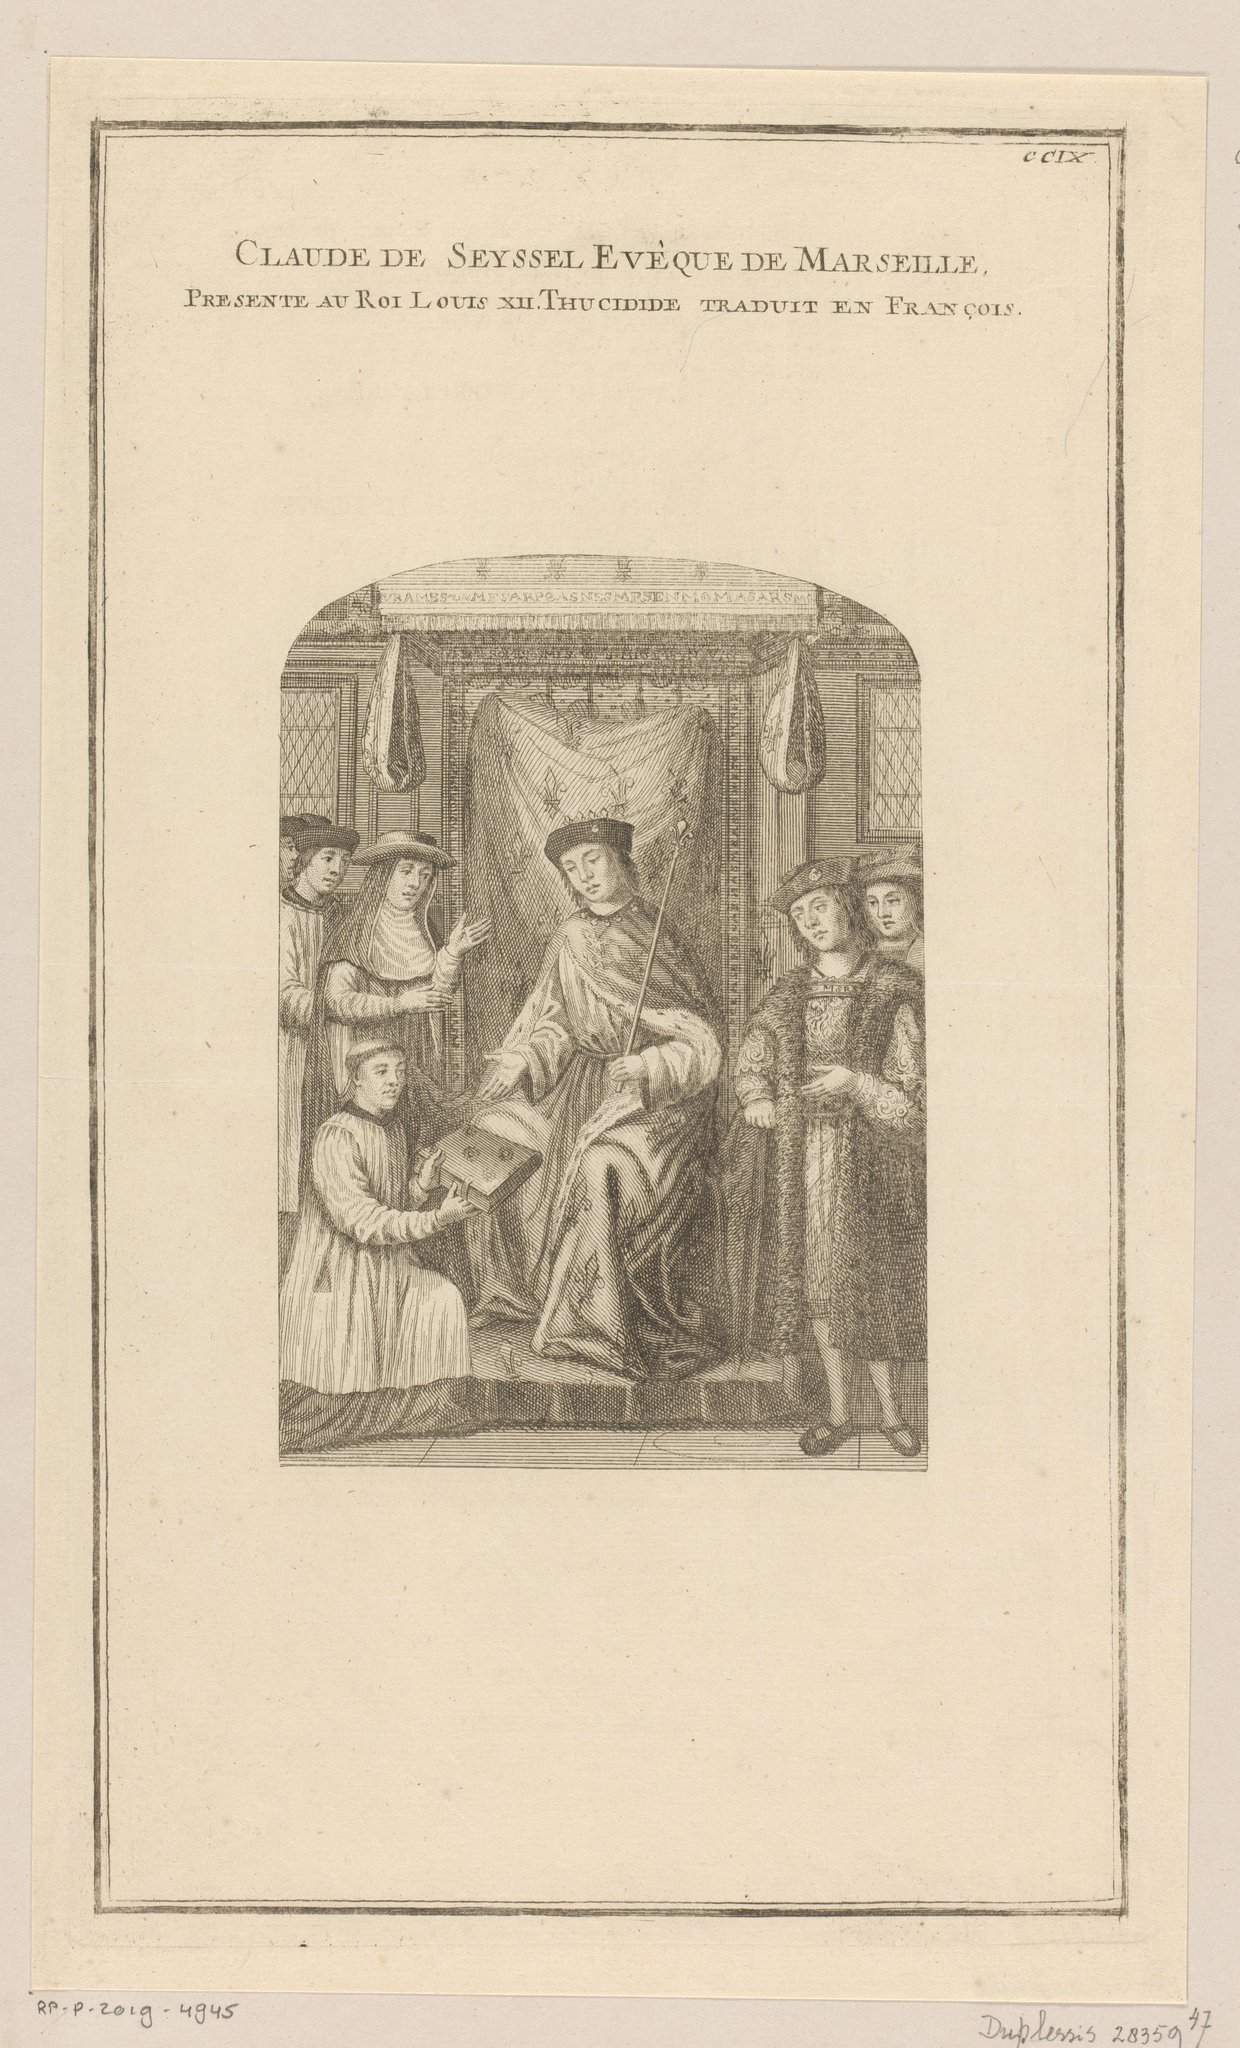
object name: print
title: Claude de Seyssel presenteert zijn Franse vertaling van Thucydides aan Lodewijk XII, koning van Frankrijk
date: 1750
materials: paper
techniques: etching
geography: london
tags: paris, historical persons, book, throne-room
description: Prent uit: Montfaucon, Bernard de. A collection of regal and ecclesiastical antiquities of France (...). Londen: William Innys, John en Paul Knapton, R. Manby en Henry Shute Cox, 1750, dl. 2. Prent voor het eerst, met andere nummering, verschenen in: Montfaucon, Bernard de. Les monumens de la Monarchie Françoise (...). Parijs: Julien-Michel Gandouin en Pierre-François Giffart, 1729-1733.